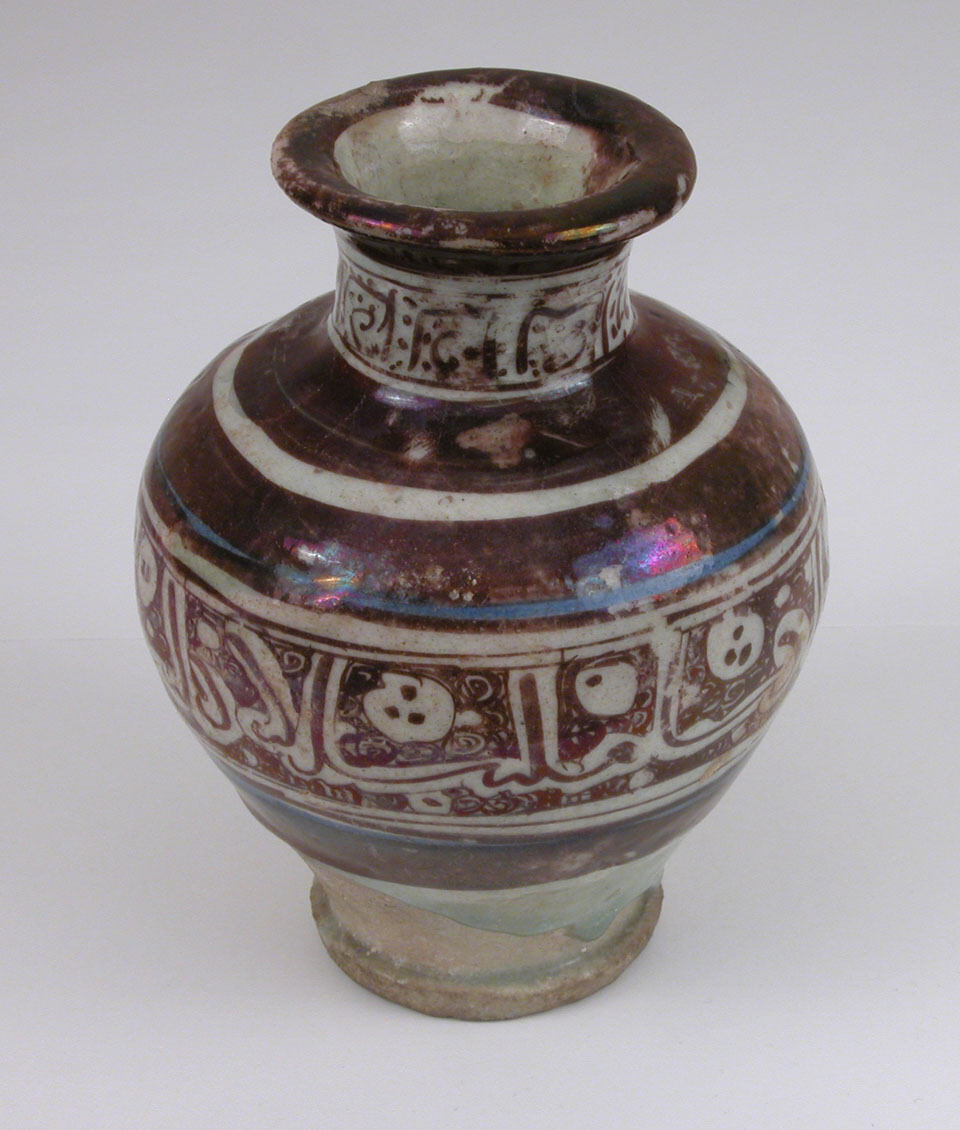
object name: vase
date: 1101-1300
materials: stonepaste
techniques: luster painting, underglaze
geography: syria